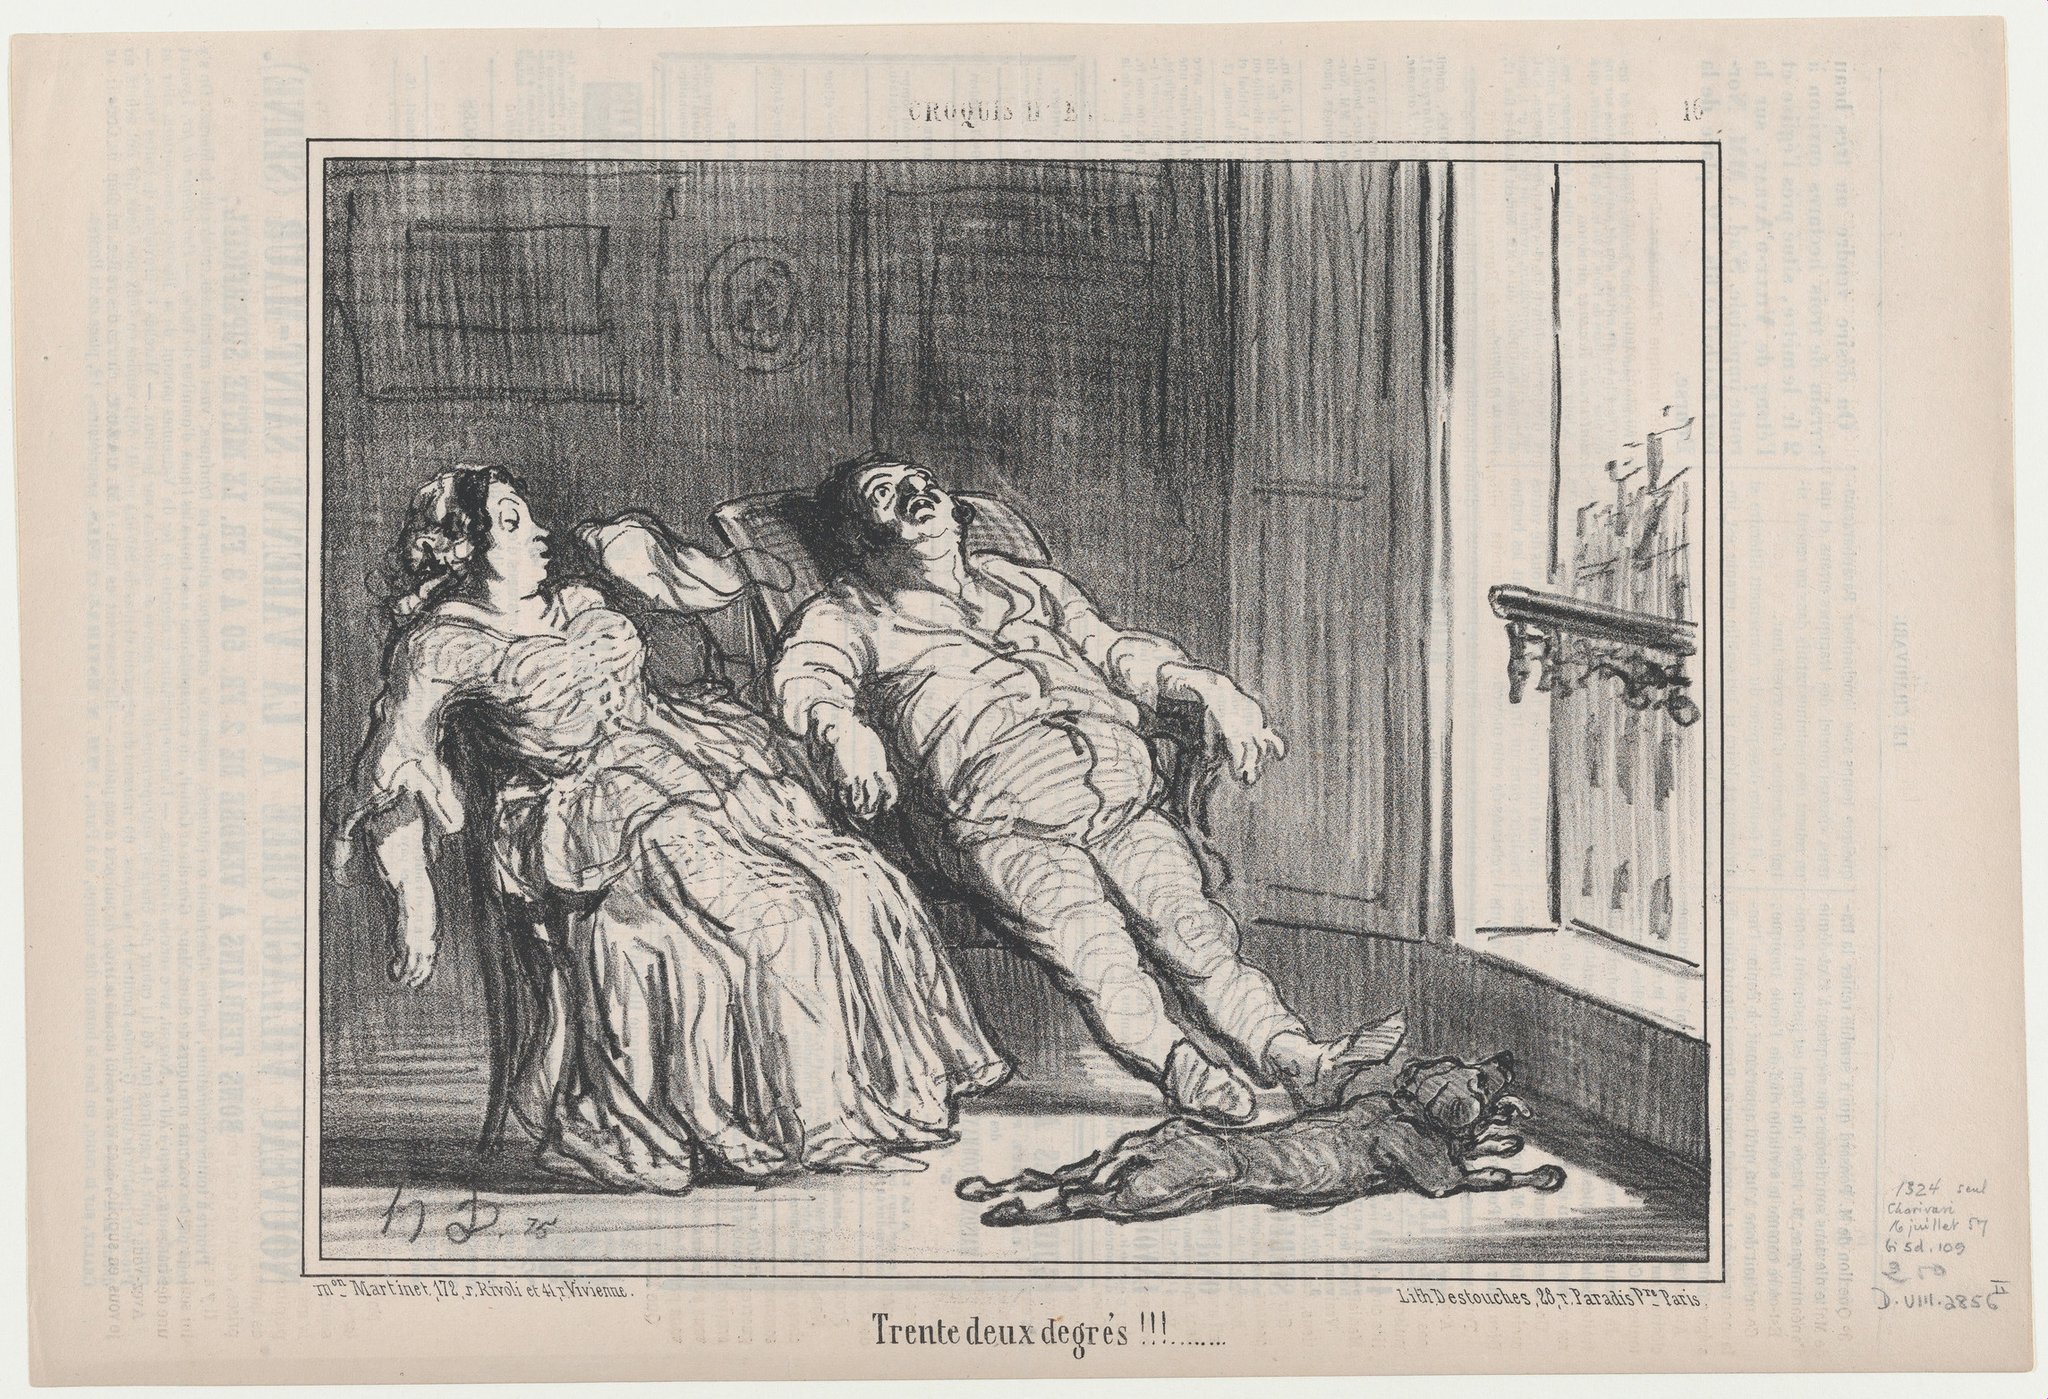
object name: print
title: Trente deux degrés, from Croquis d'Été, published in Le Charivari, July 16, 1857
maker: honoré daumier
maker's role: artist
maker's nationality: french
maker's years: 1808-1879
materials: paper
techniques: lithograph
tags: men,women,dogs,summer